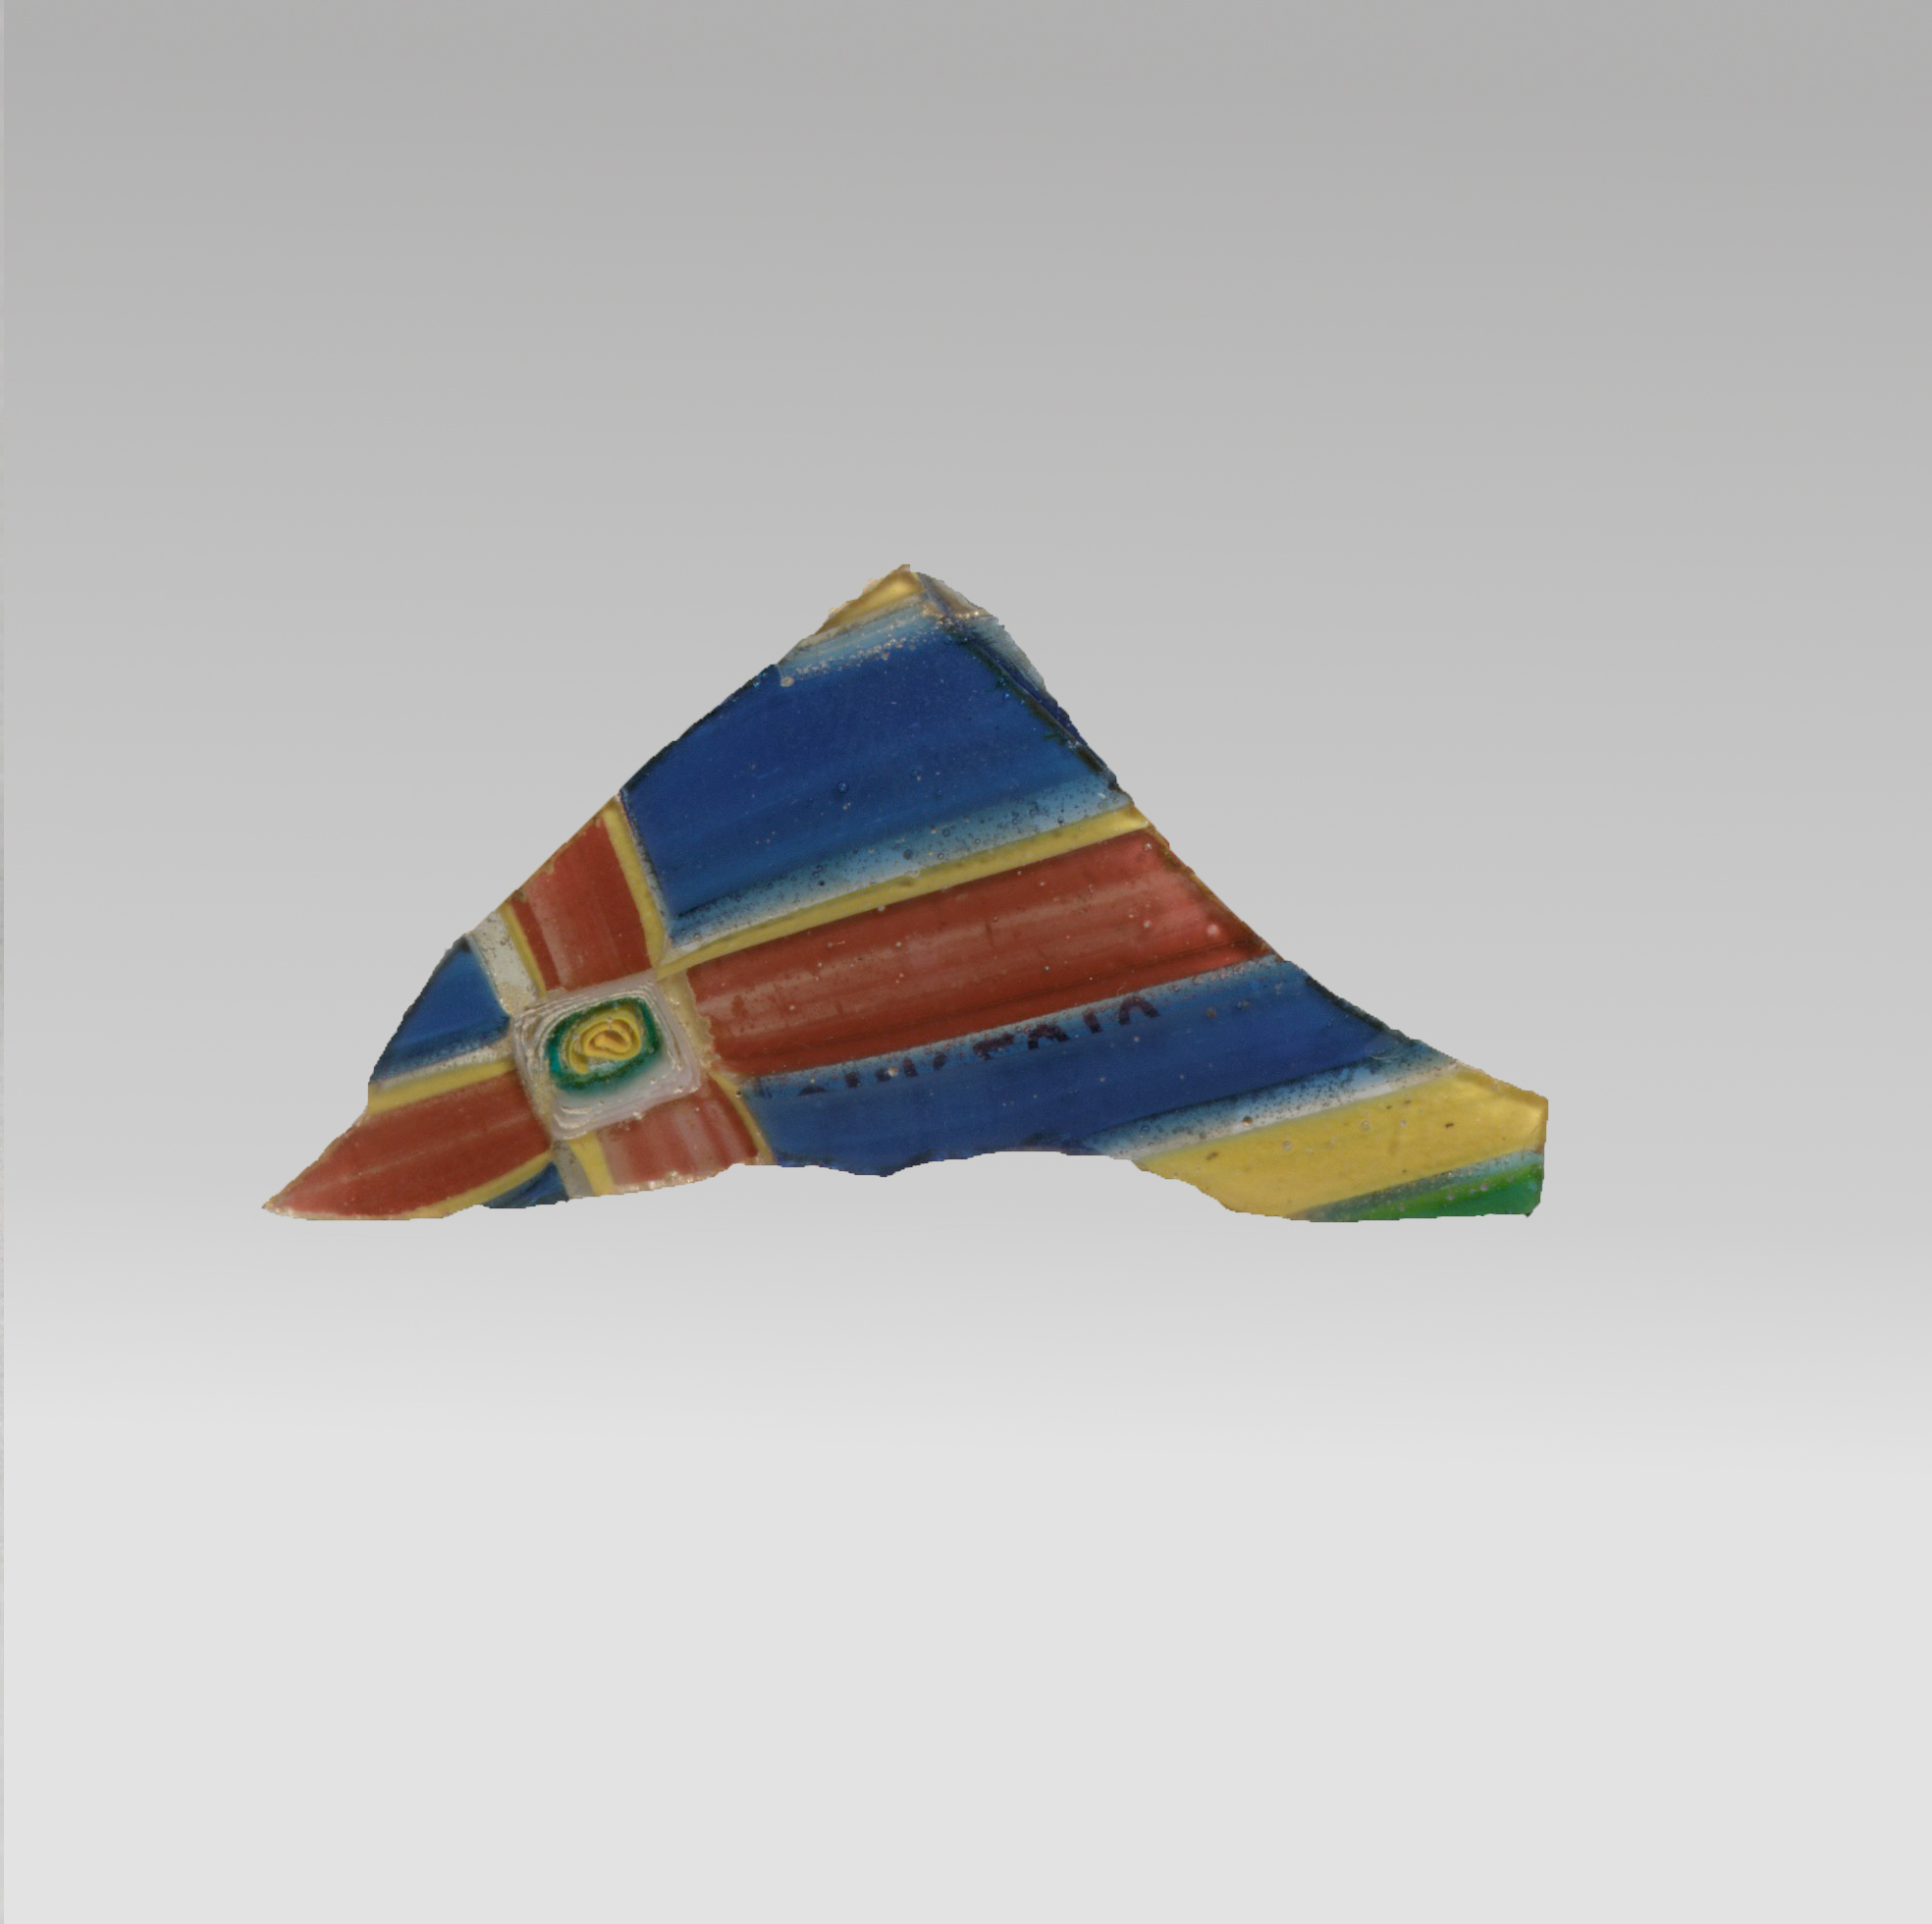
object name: fragment, striped mosaic, quadripartite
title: Glass striped mosaic bowl fragment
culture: roman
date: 34 BCE-33 CE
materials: glass